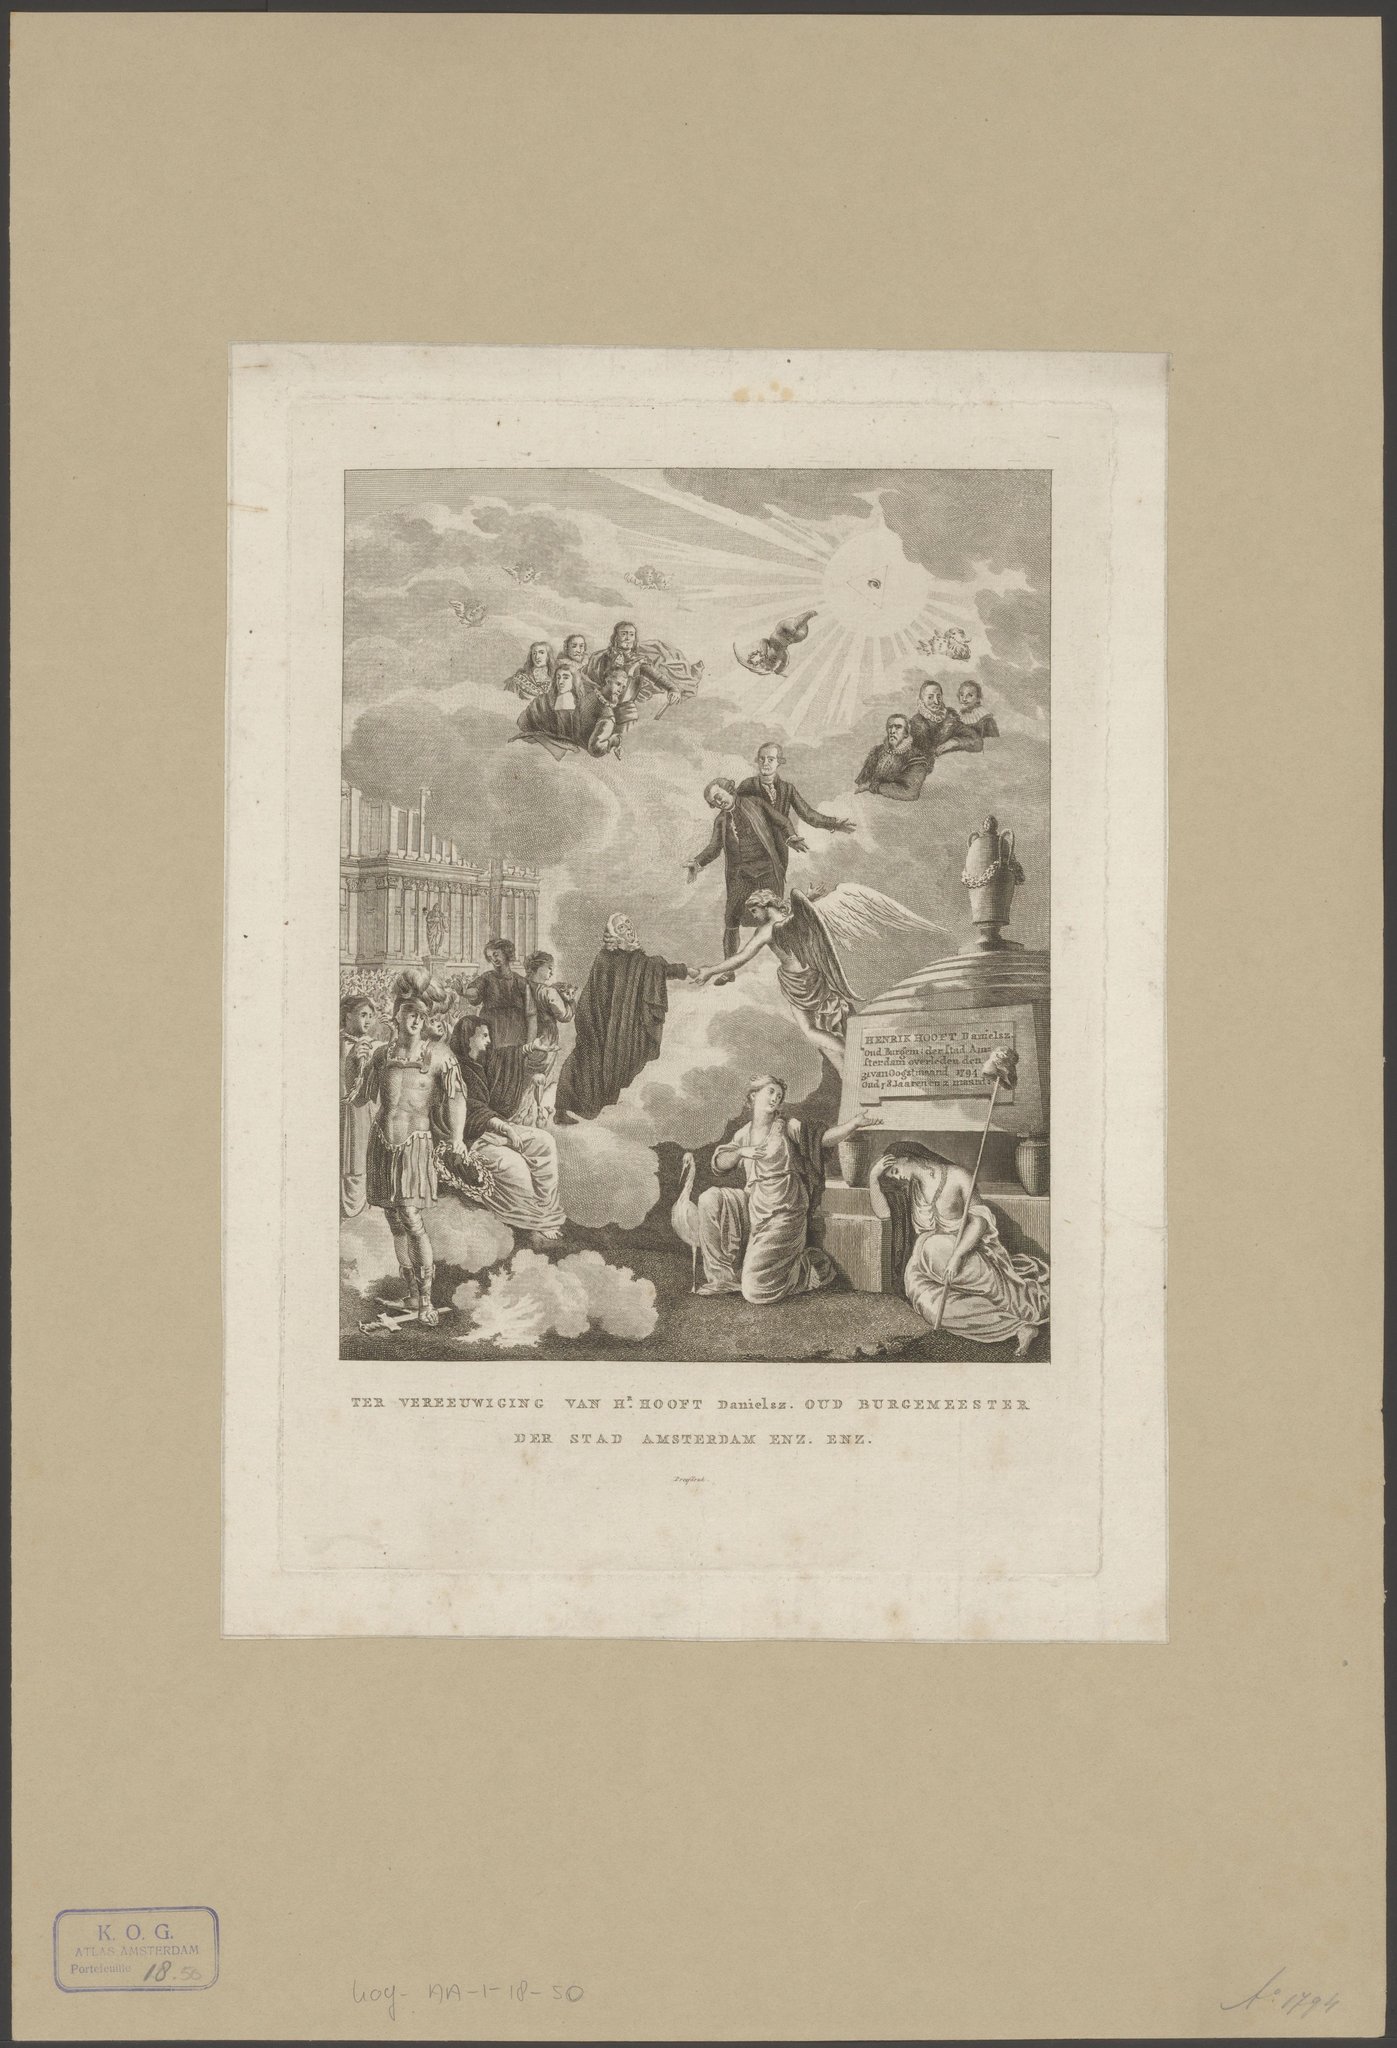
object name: print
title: Ter vereeuwiging van Hr. Hooft Danielsz. oud burgemeester / der stad Amsterdam enz. enz.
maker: Anonymous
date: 1794-1850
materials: paper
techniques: etching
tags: amsterdam, mayor, hendrik danielsz. hooft, personification of a city, town-patron(ess), mayor, burgomaster, the all-seeing eye, triangle with eye ~ symbol of god the father, grave-building, monumental tomb, patriot (revolutionary)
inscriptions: collector's mark: ‘18.50’ Lugt 1641b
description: Onderwerpsrubriek binnen de Atlas Amsterdam: Herinneringen aan regeringsleden en hunne huisgezinnen [voor 1800].